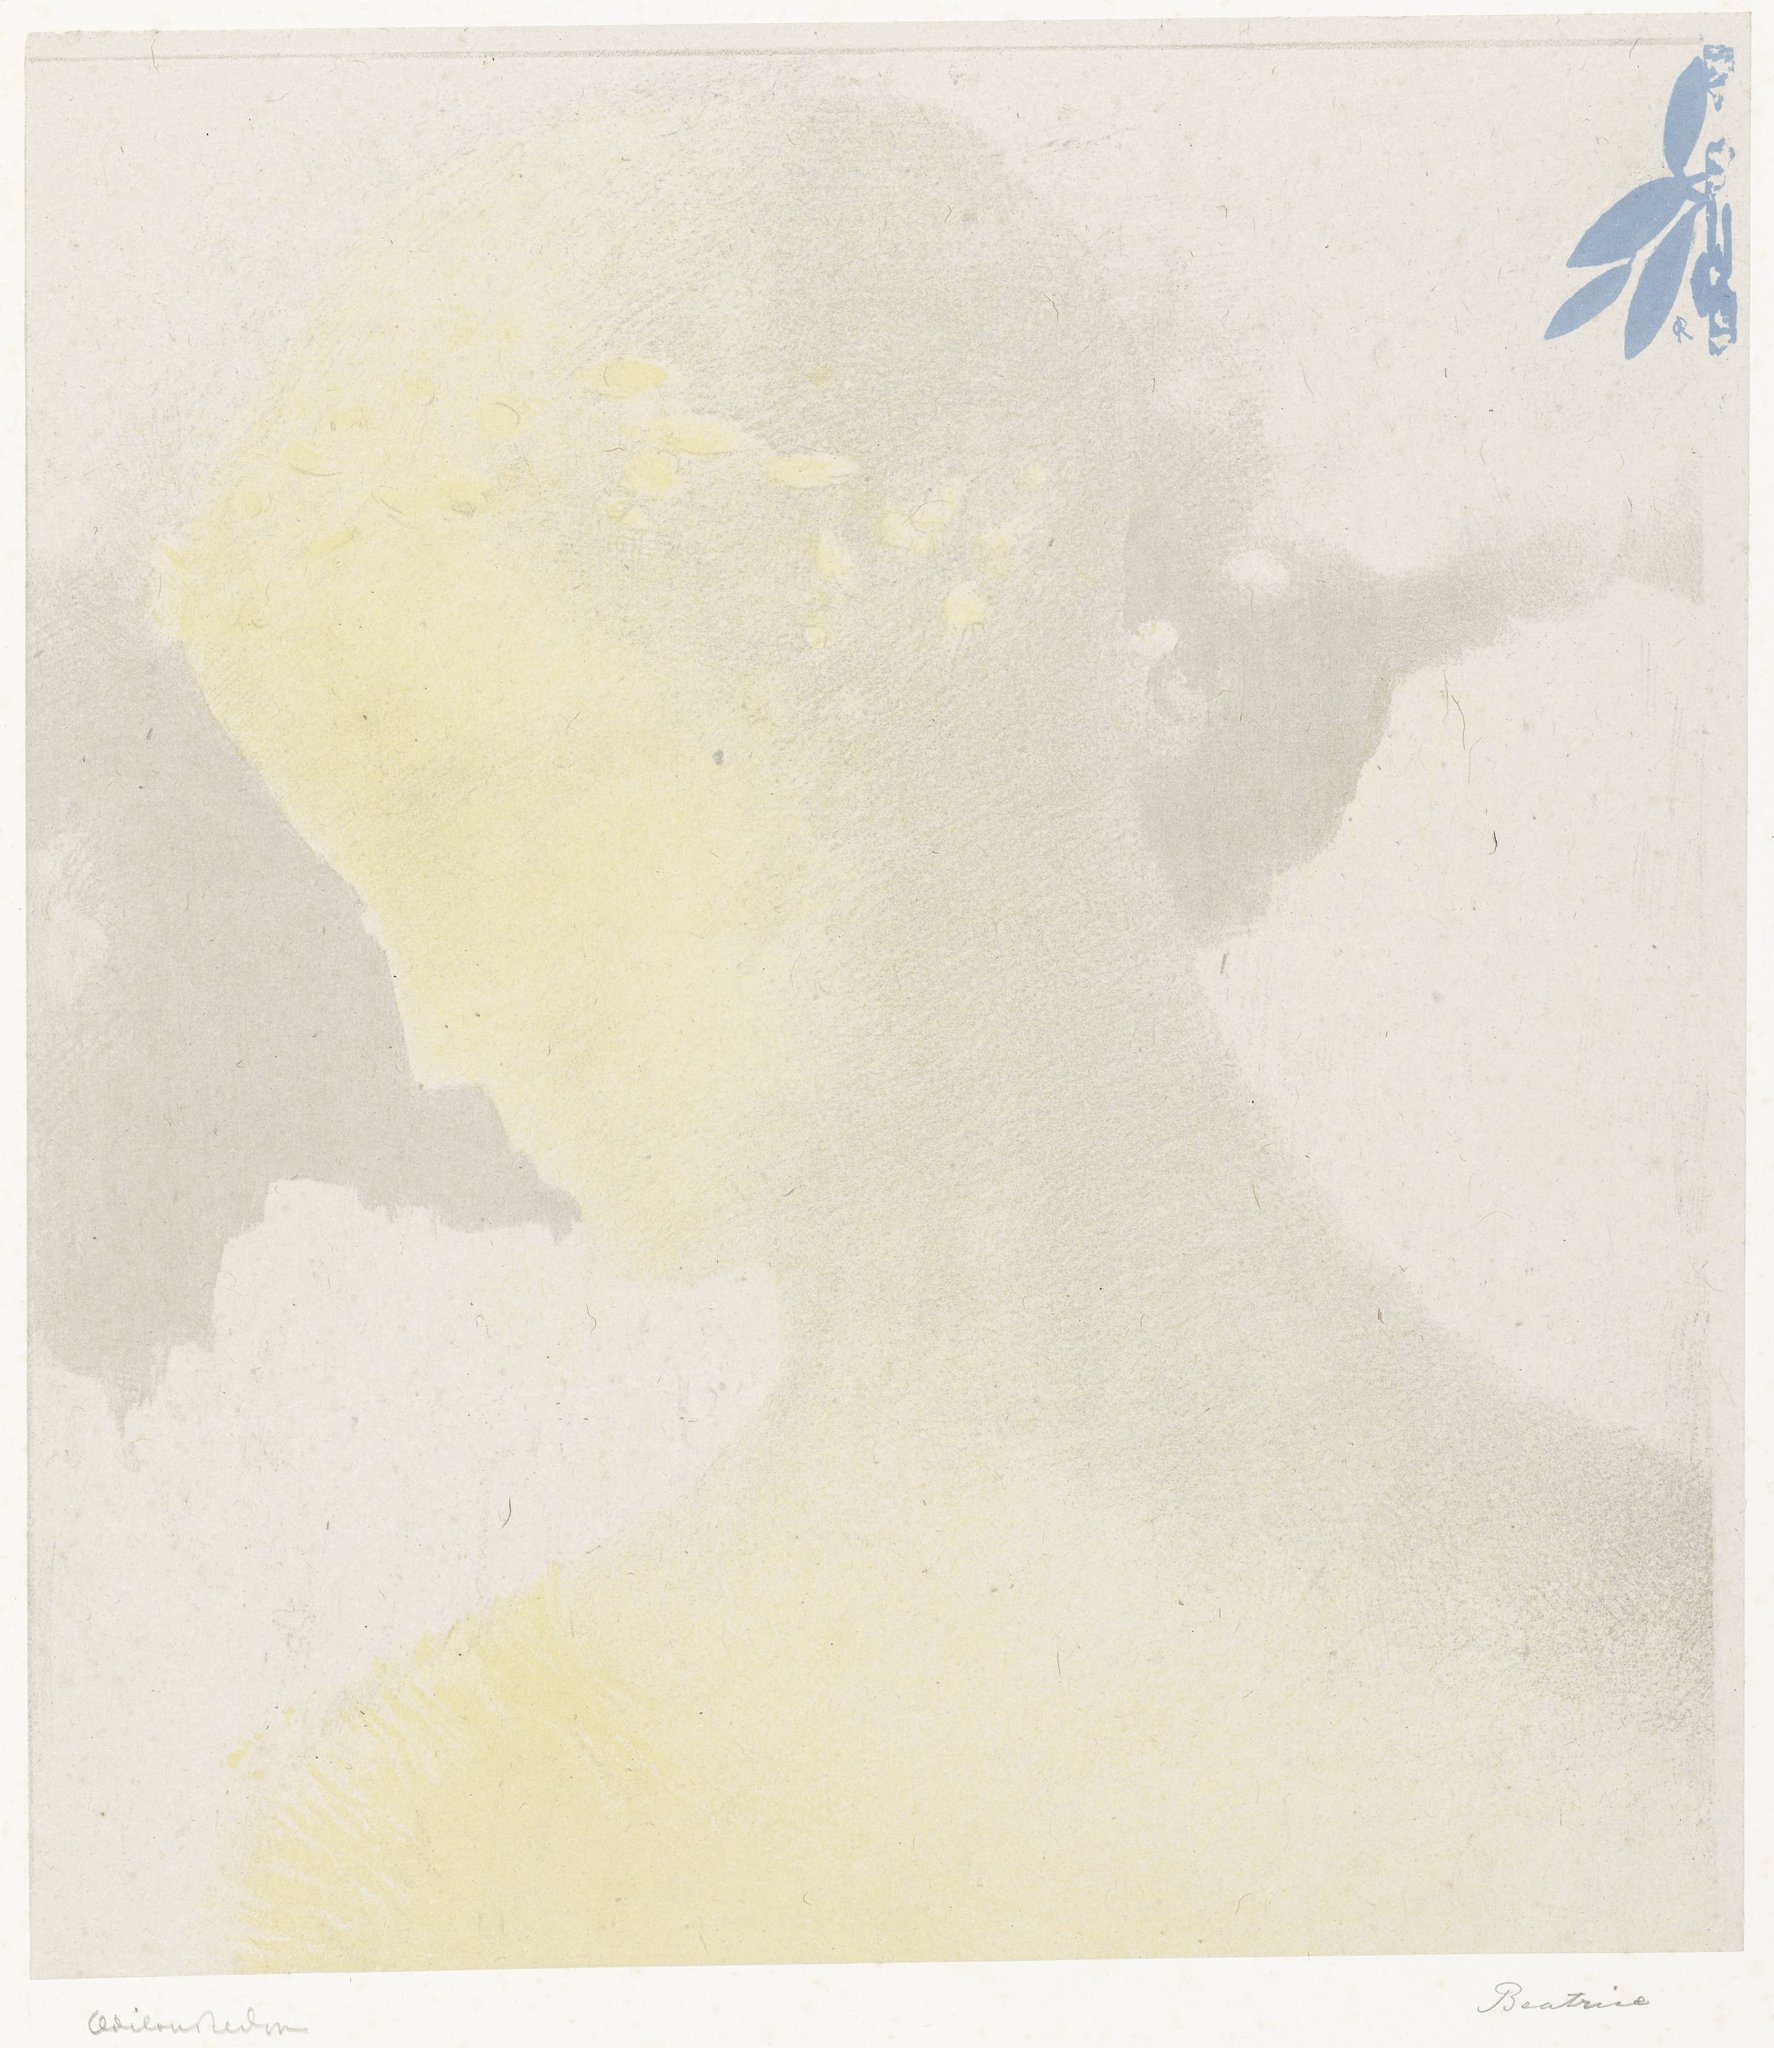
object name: print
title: Beatrice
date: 1897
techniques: printmaking, printing, lithograph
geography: paris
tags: adult woman (+ sideview, profile)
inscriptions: collector's mark: Lugt 2228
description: Prent gemaakt in opdracht van Ambroise Vollard voor het "Album d'estampes originales de la Galerie Vollard", uitgegeven door Vollard in december 1897. Eén van 32 prenten gemaakt door verschillende kunstenaars. K.Botke